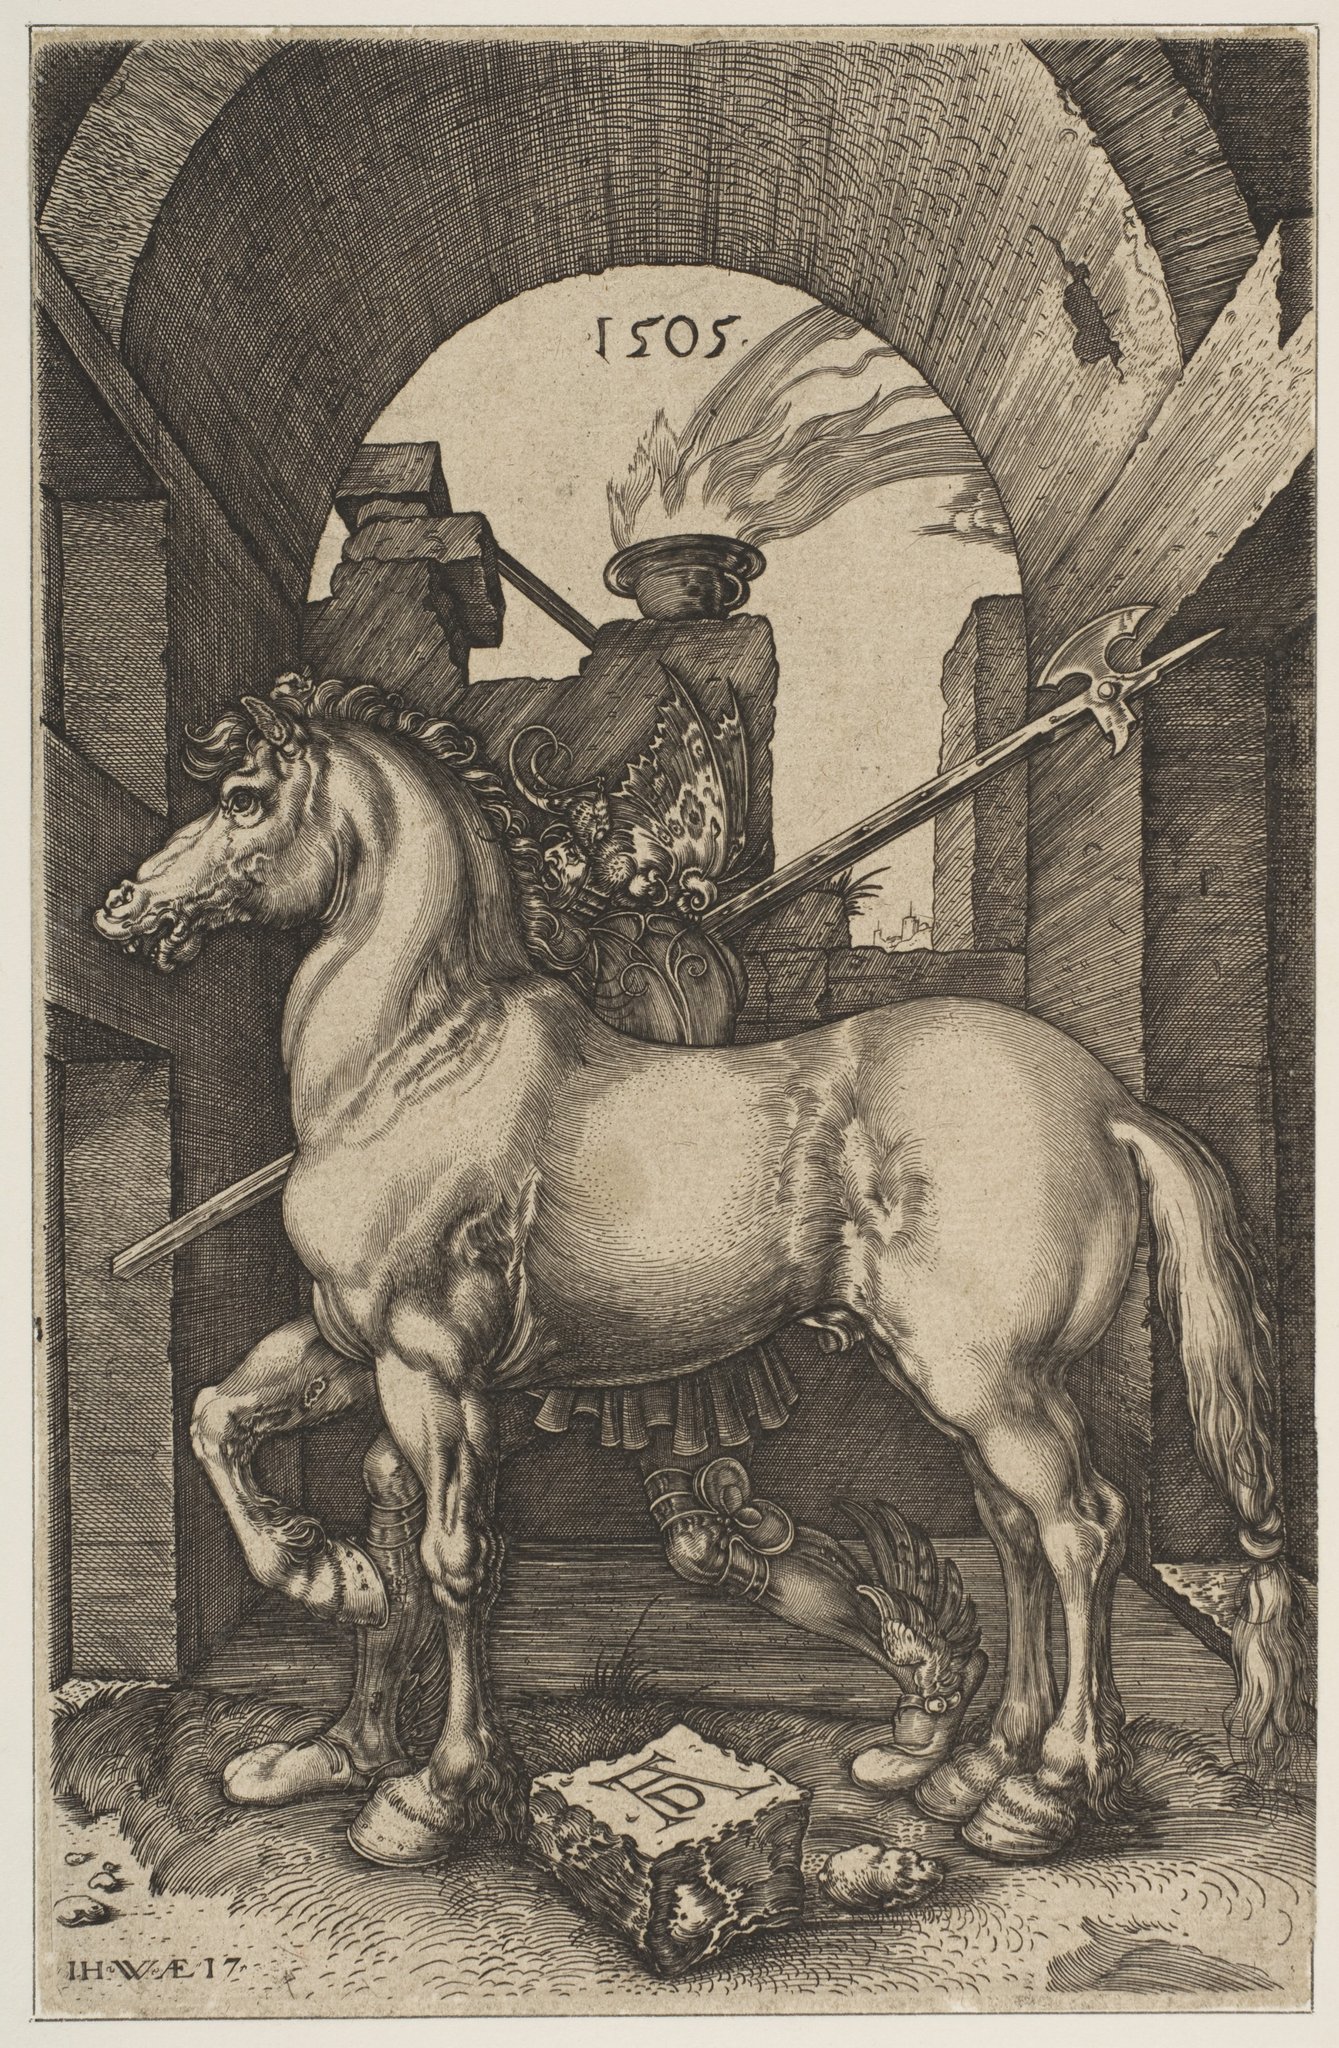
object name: print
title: The Little Horse (copy)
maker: jan (johannes) wierix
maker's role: artist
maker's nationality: netherlandish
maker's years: 1549-1615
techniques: engraving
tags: horses